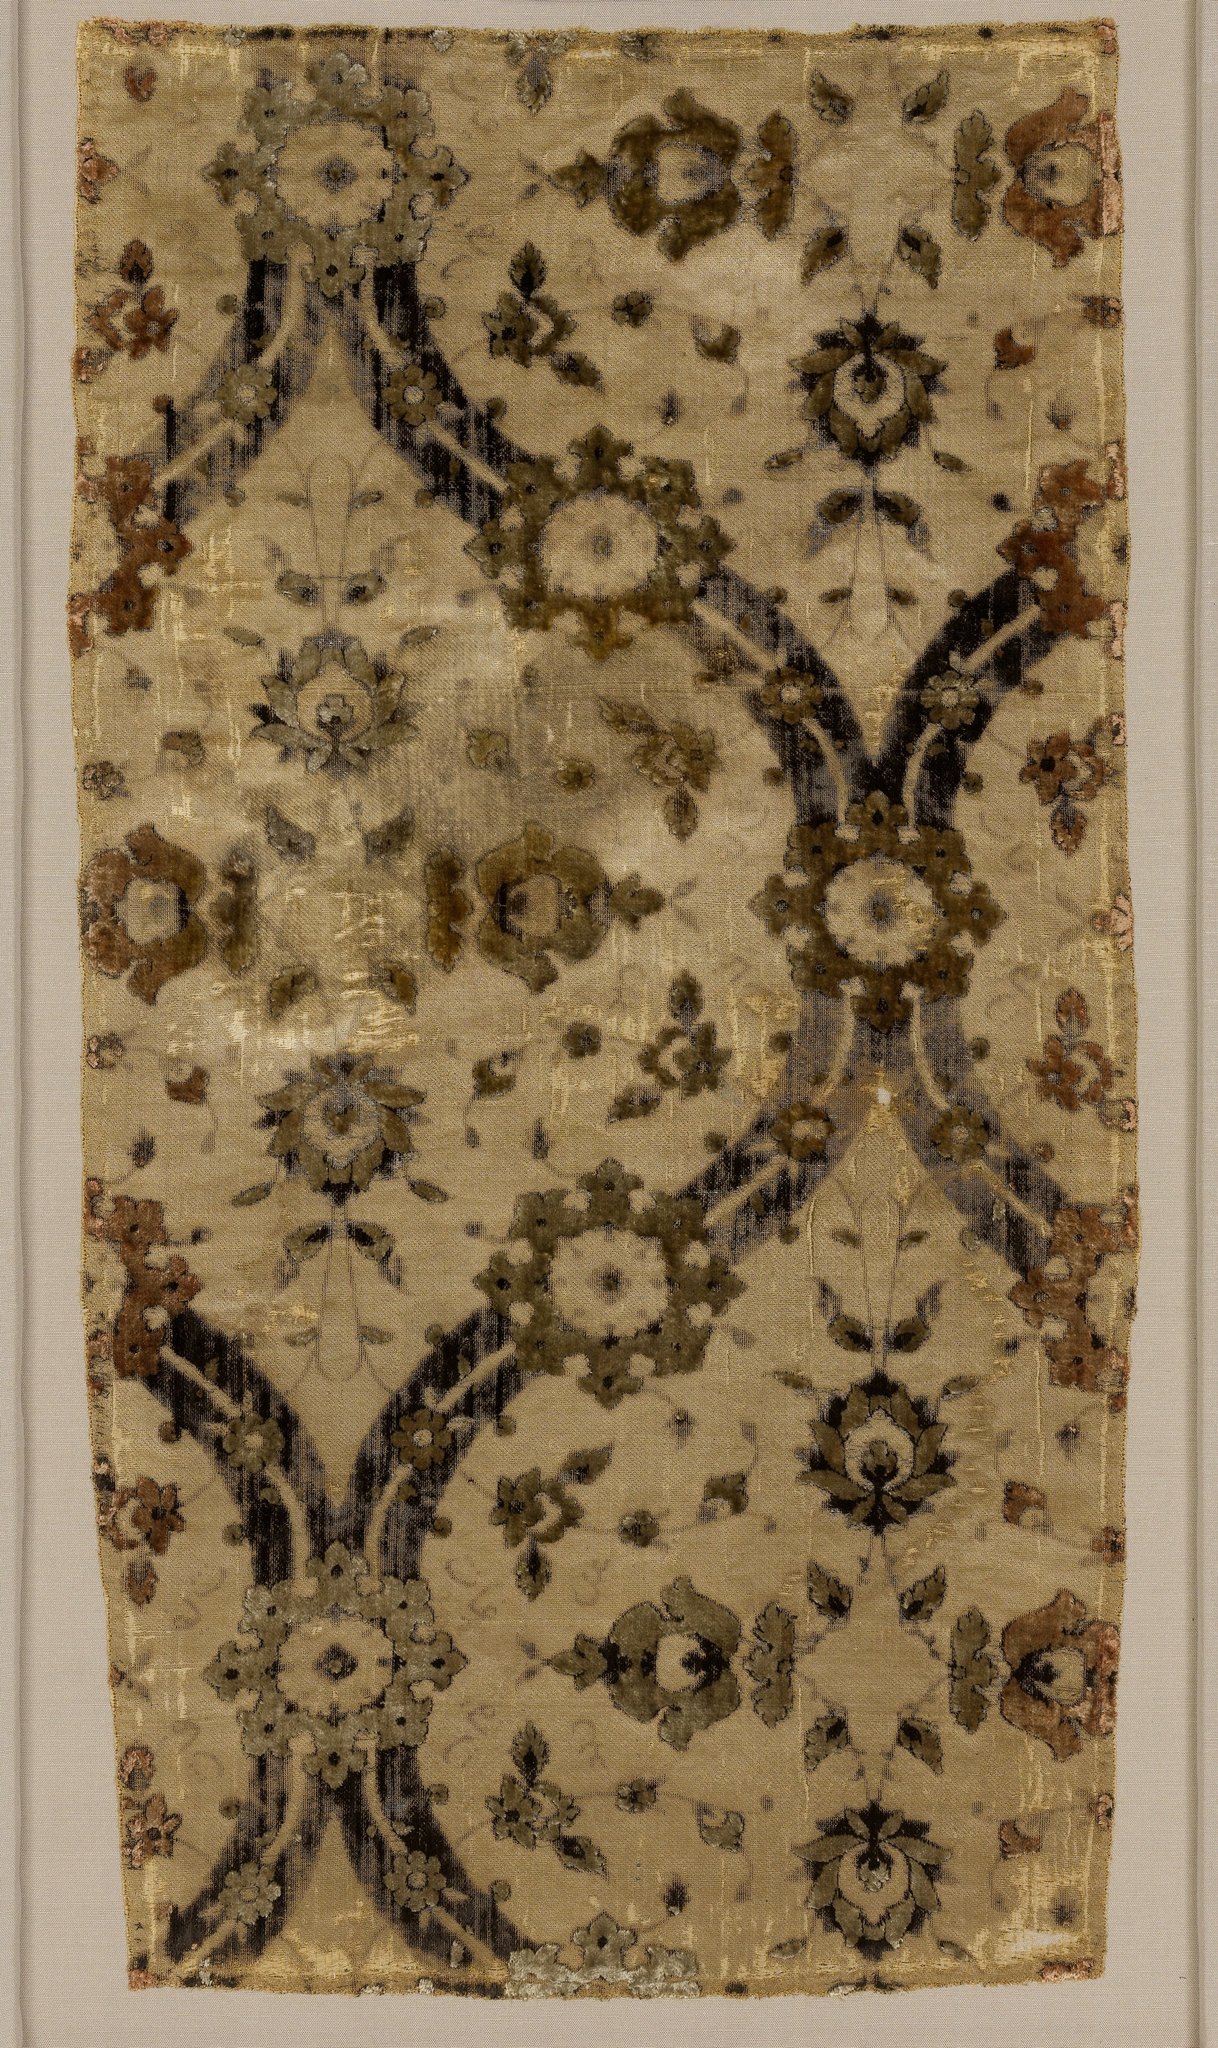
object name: textile fragment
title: Silk Velvet Designed by 'Ghiyath'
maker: ghiyath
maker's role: maker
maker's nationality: iranian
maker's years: 1515-1600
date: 1551-1600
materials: metal thread, silk, velvet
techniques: cutting, voiding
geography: iran